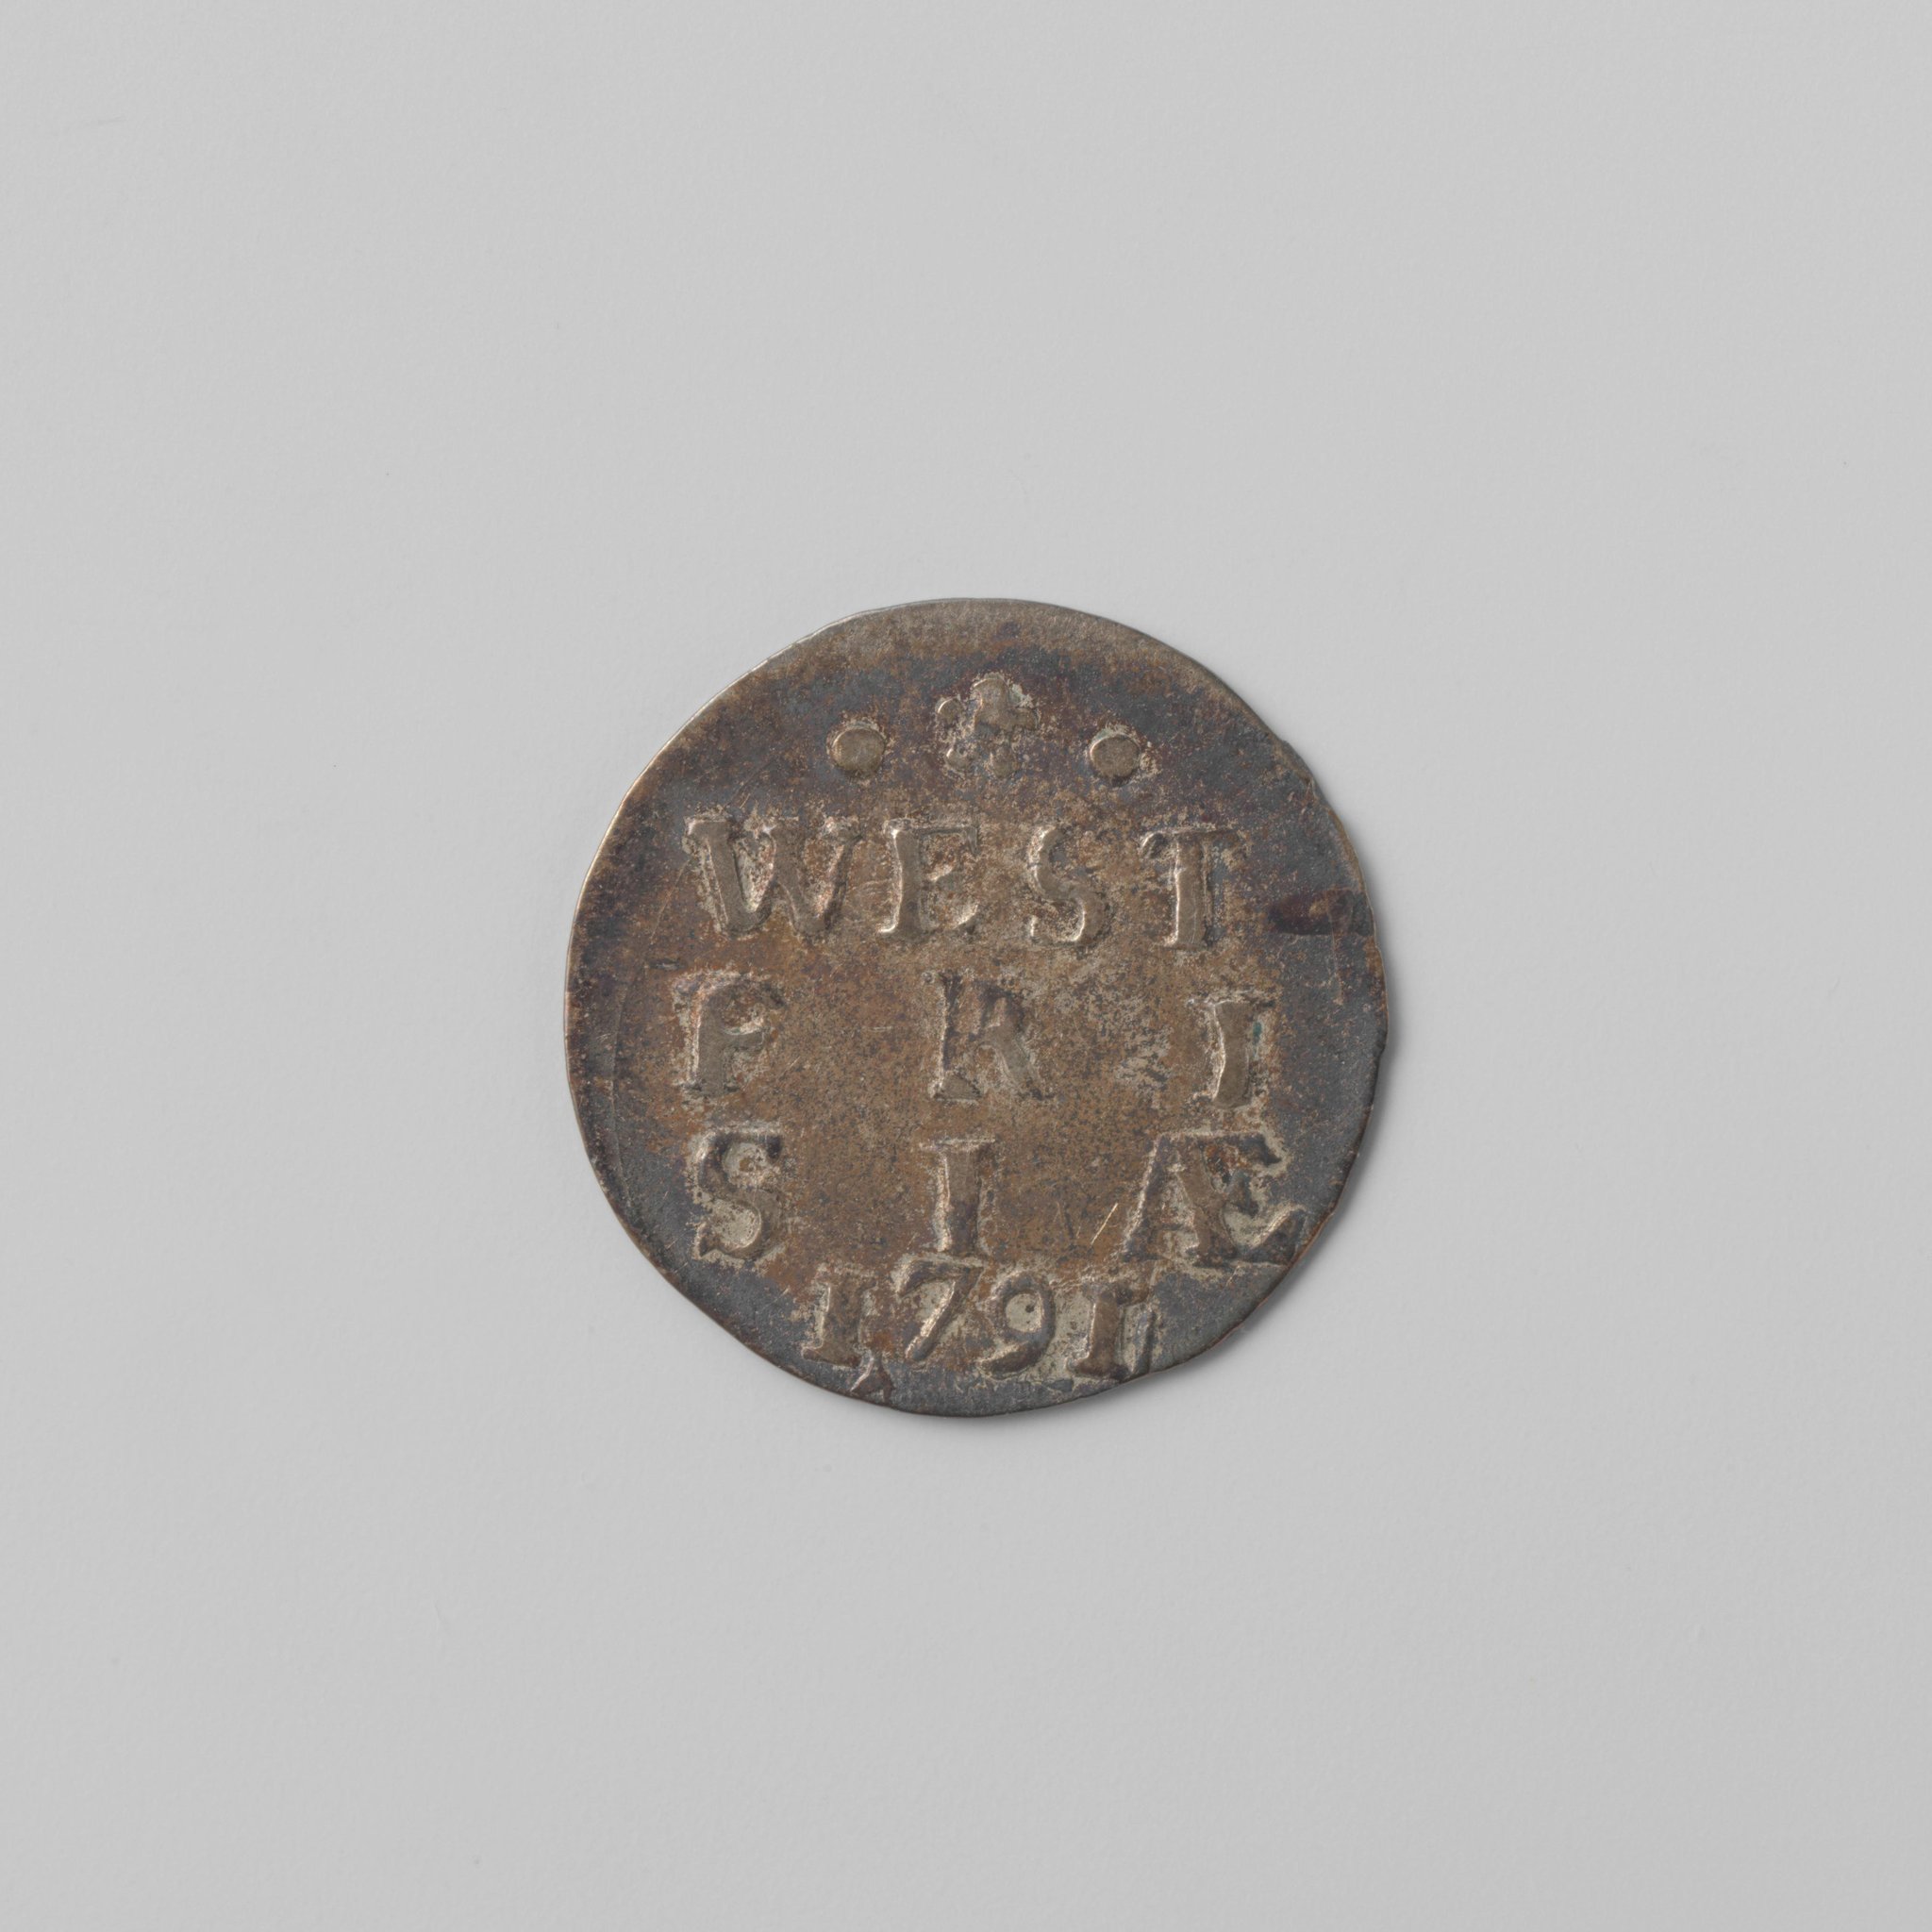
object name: coin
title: West-Friesland, dubbele stuiver, 1791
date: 1791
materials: silver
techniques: striking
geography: west frisia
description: Zilveren munt. Voorzijde: tussen waarde-aanduiding 2 S gekroond wapenschild van West-Friesland. Keerzijde: opschrift in drie regels. Daarboven muntteken tussen twee punten, daaronder jaartal.